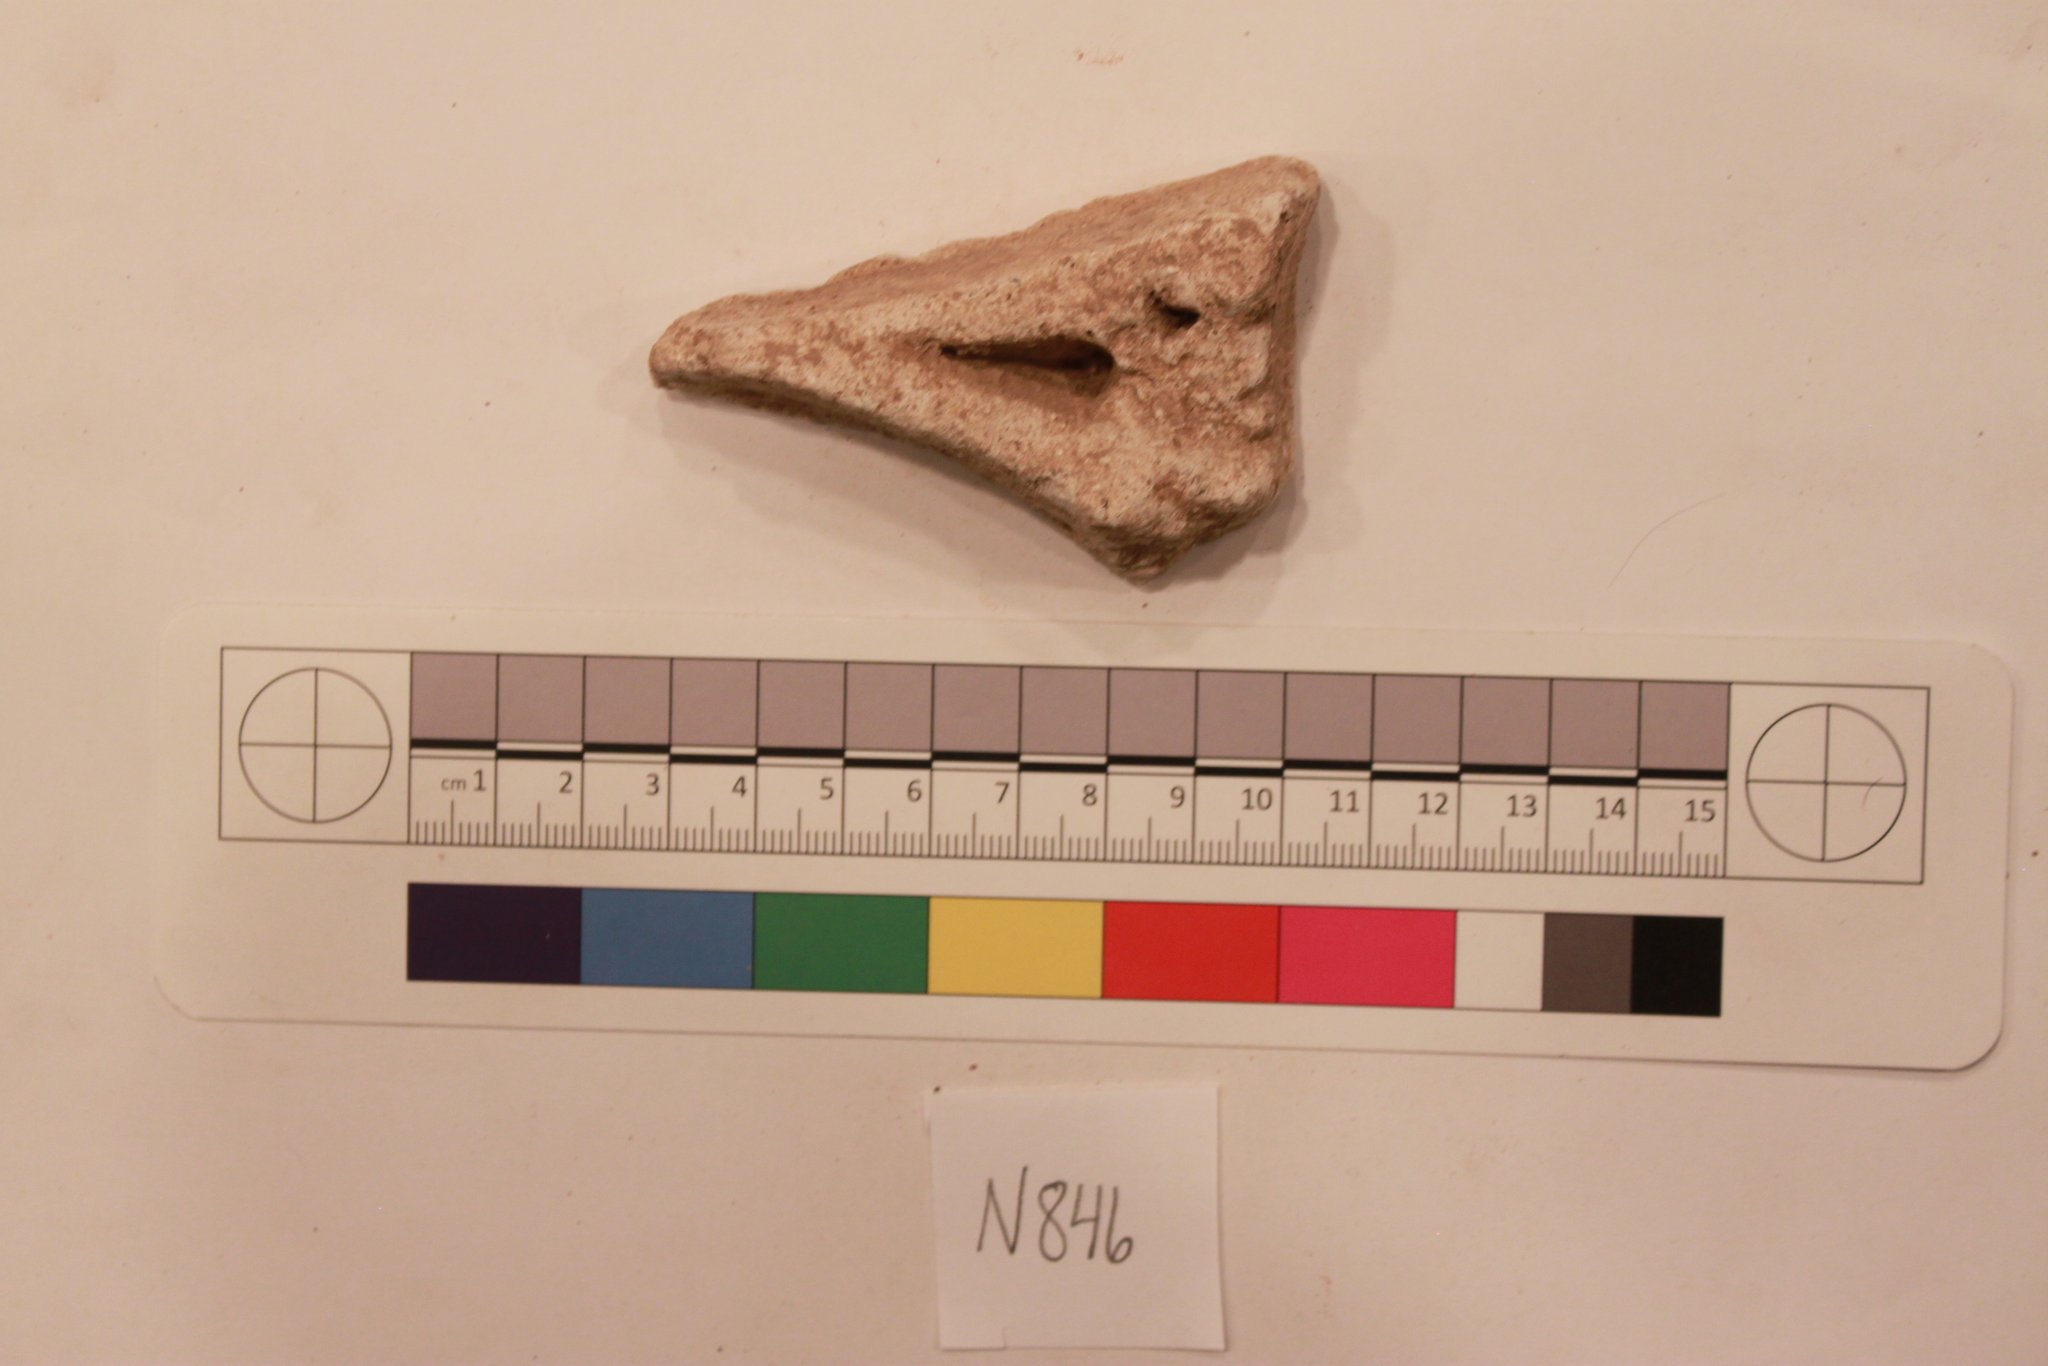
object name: fragment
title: Stucco Fragment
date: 701-1200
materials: plaster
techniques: carving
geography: iran